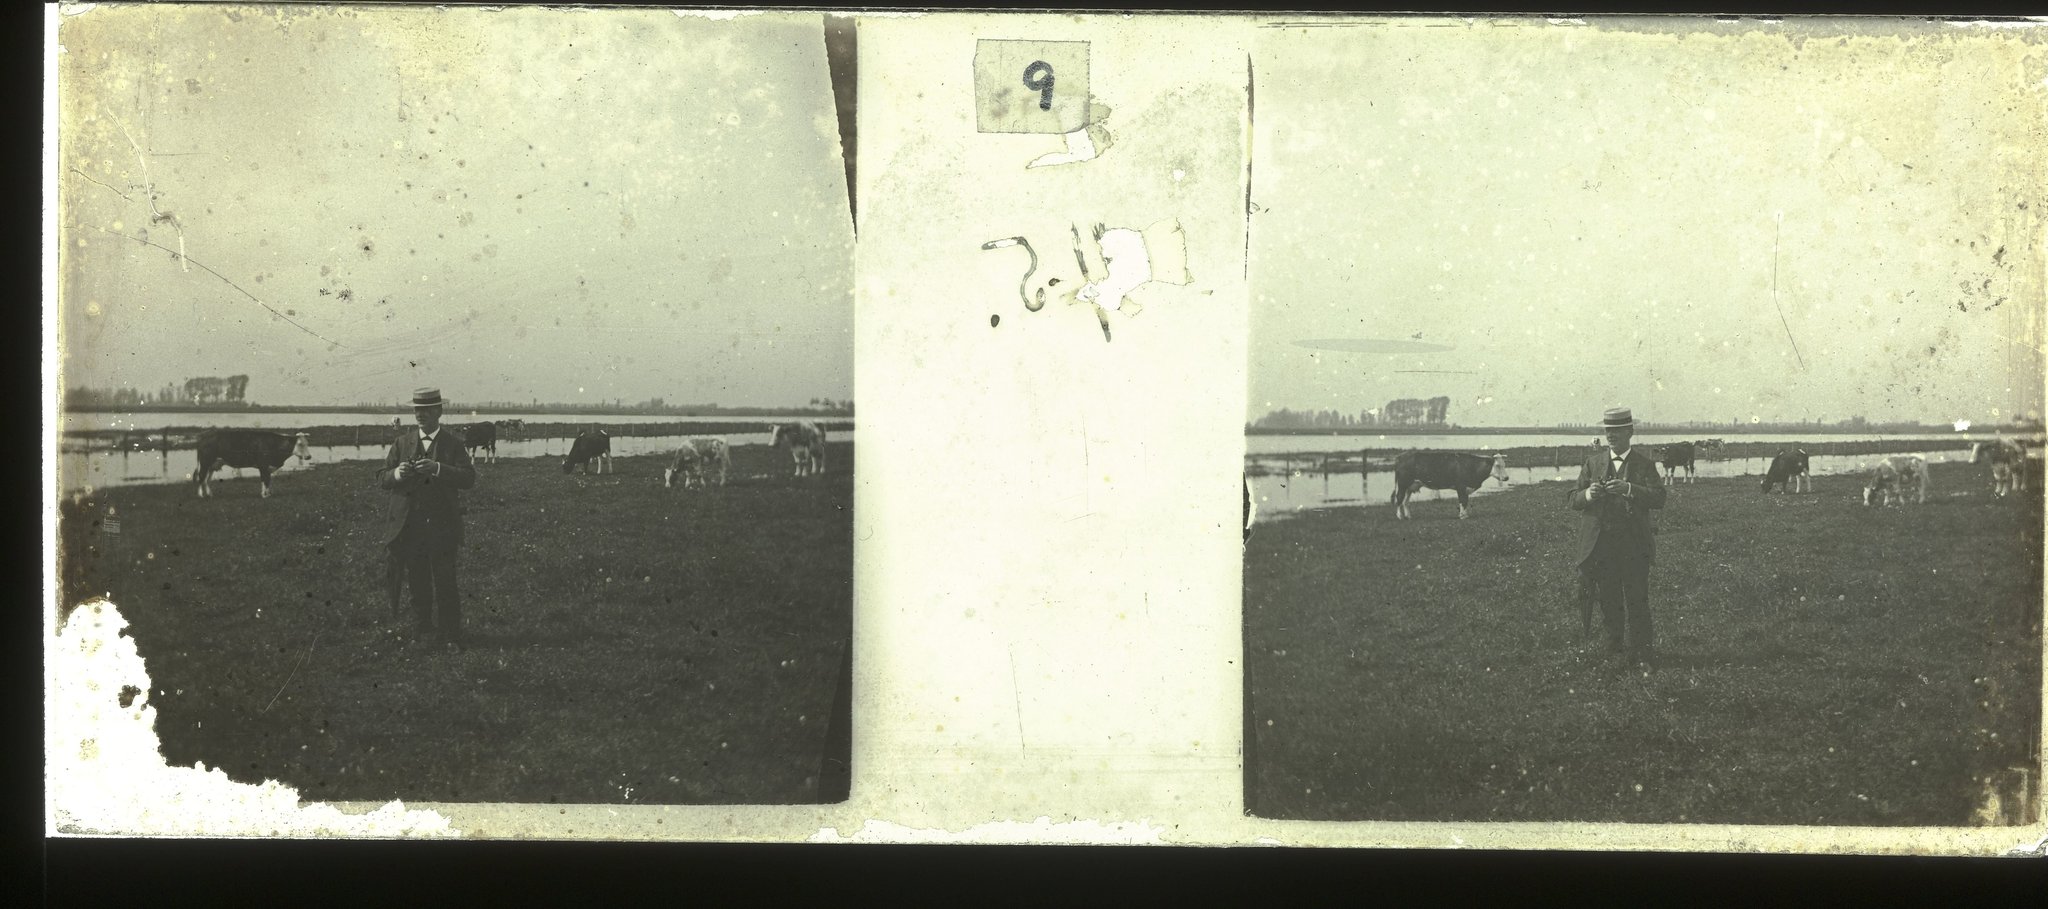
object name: stereograph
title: Koeien in Nederland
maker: theodoor brouwers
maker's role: amateurfotograaf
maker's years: 1874-1932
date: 1913-1930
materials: glass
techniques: photography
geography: netherlands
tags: amsterdam, theodoor brouwers, netherlands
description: In de periode 1911-1932 woonde op plantage Accaribo in Suriname de familie Brouwers van wie de foto's afkomstig zijn. Rond 1910 vond Theodoor Brouwers werk op plantage Accaribo. In 1929 werd hij eigenaar van de plantage. Op Accaribo werden in zijn tijd bananen geproduceerd en wat koffie.